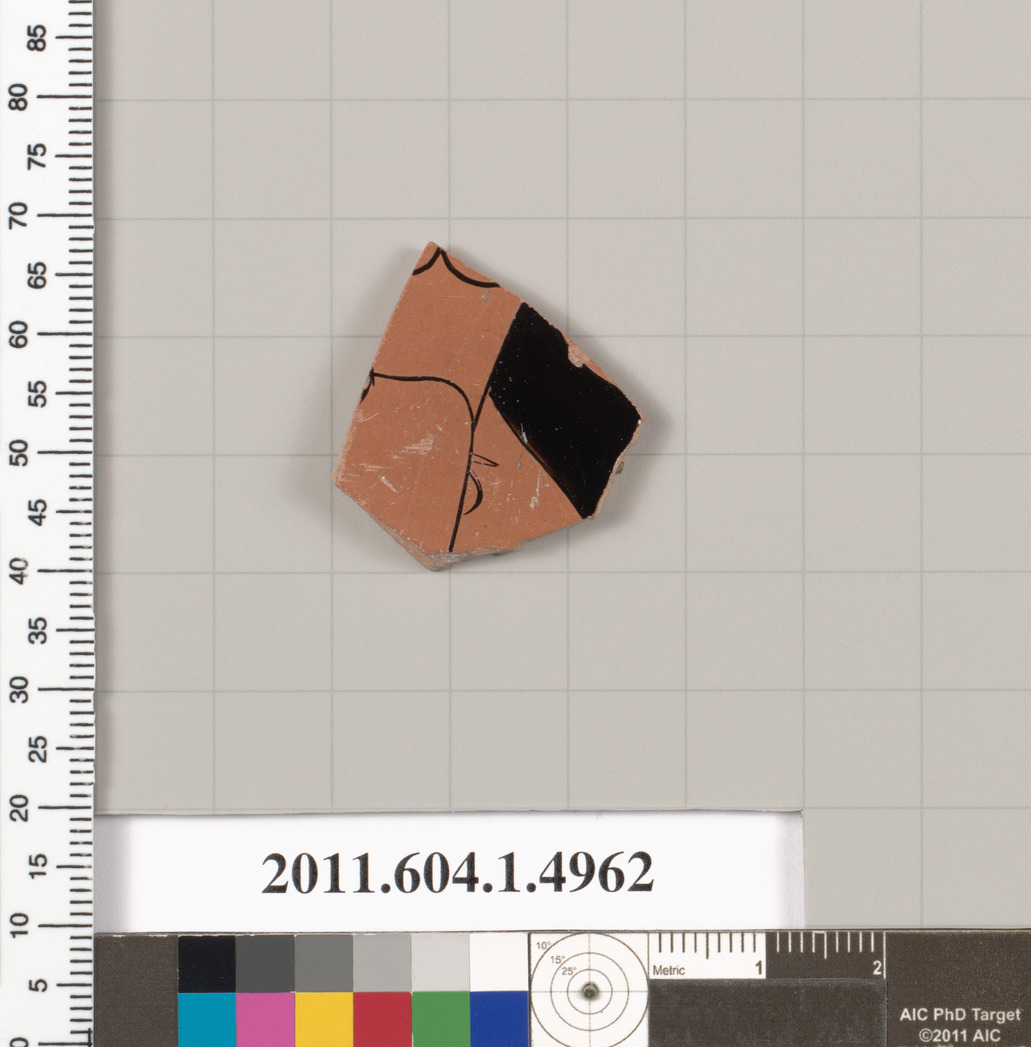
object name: kylix fragment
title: Terracotta fragment of a kylix (drinking cup)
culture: greek, attic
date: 520-500 BCE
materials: terracotta